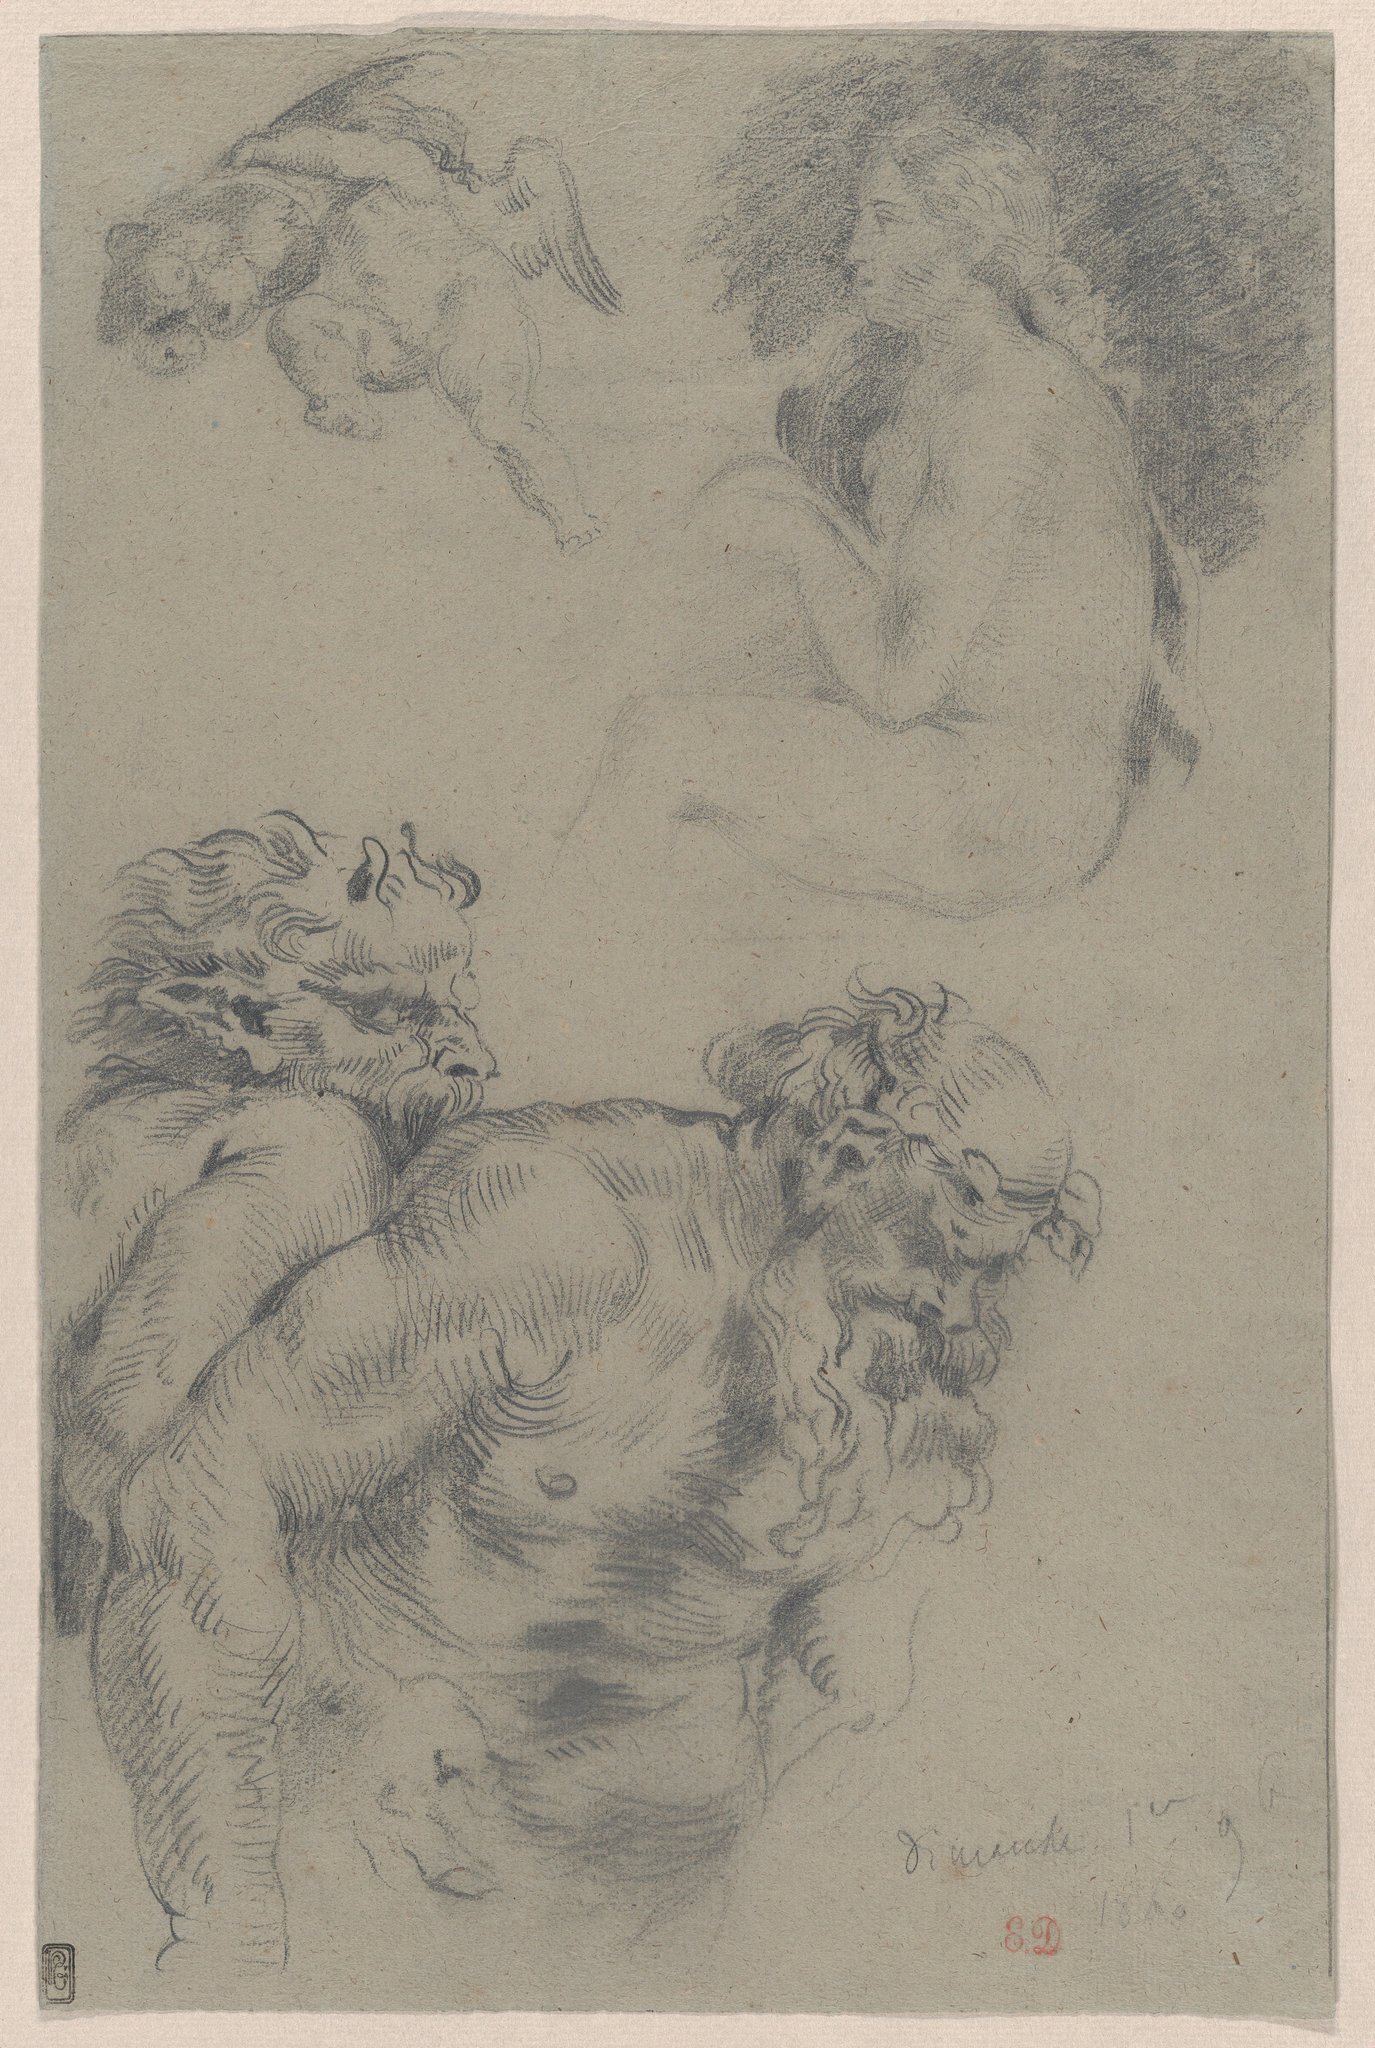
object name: drawing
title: Drunken Silenus, after Rubens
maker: eugène delacroix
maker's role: artist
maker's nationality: french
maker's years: 1798-1863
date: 1840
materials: graphite